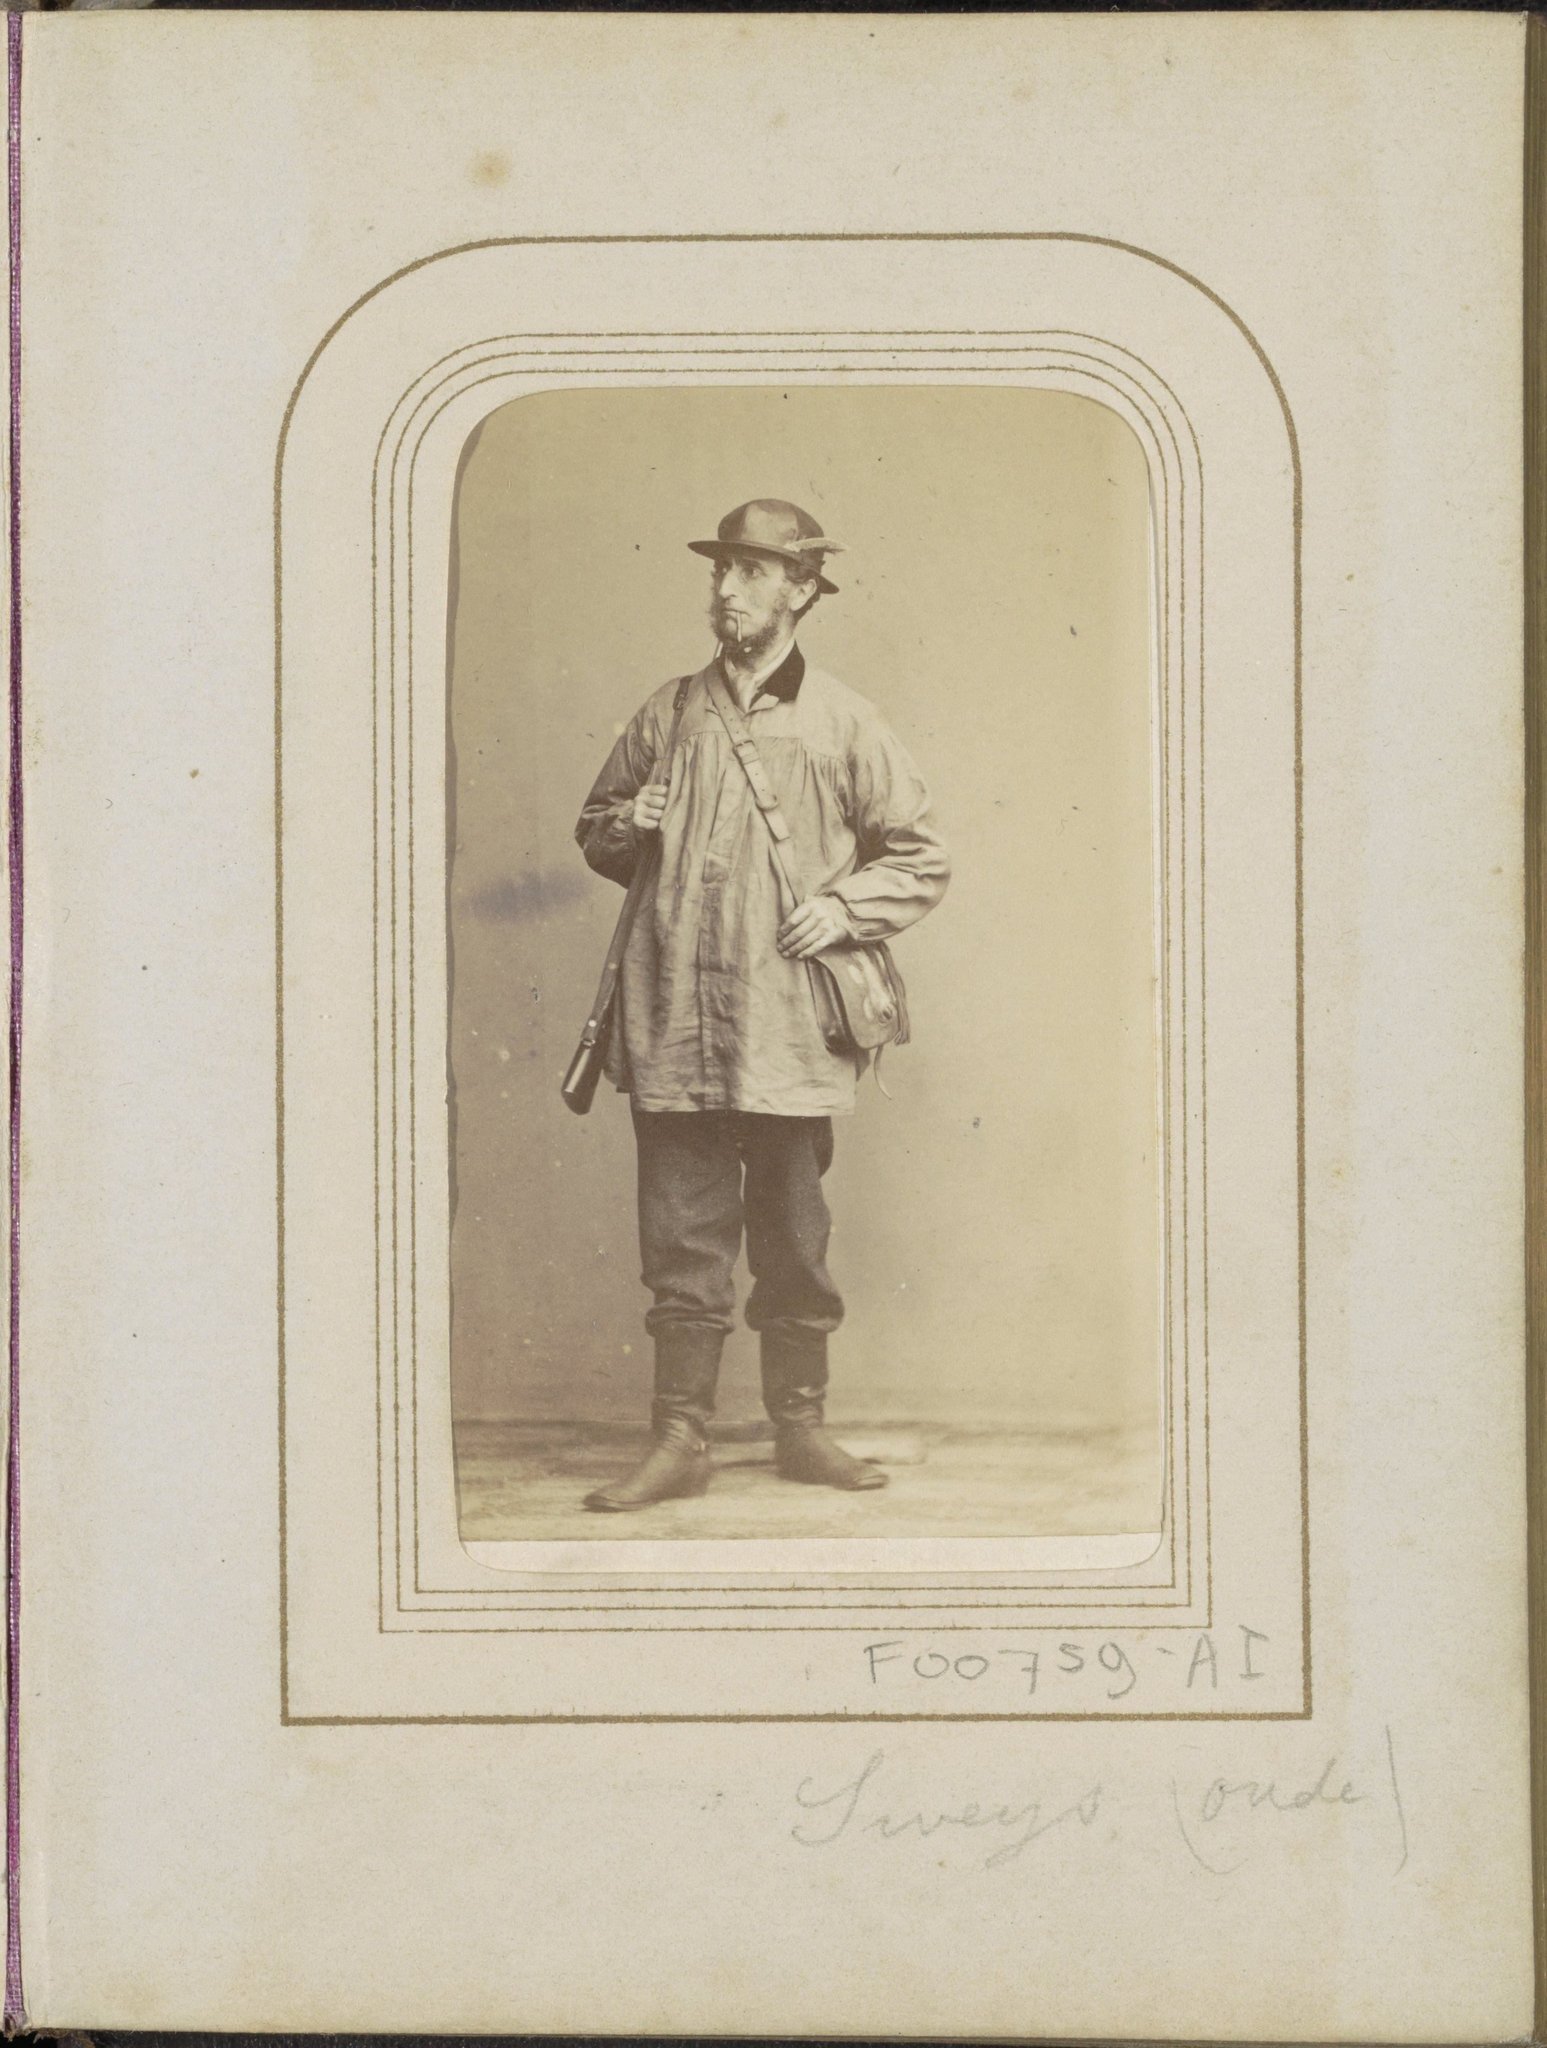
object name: carte de visite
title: Portret van een man in jachtkleding, aangeduid als Sweys (oude)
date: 1860-1875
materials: cardboard, paper, photographic support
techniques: albumen print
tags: studio requisites ~ photographer, hunter, historical persons, clothes for special purposes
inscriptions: inscription: ‘Sweys (oude)’, address: ‘Amsterdam, Kalverstraat D26; Utrecht, Leidsche Straatweg’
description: Onderdeel van Fotoalbum van een Nederlandse familie met 50 cartes-de-visite.